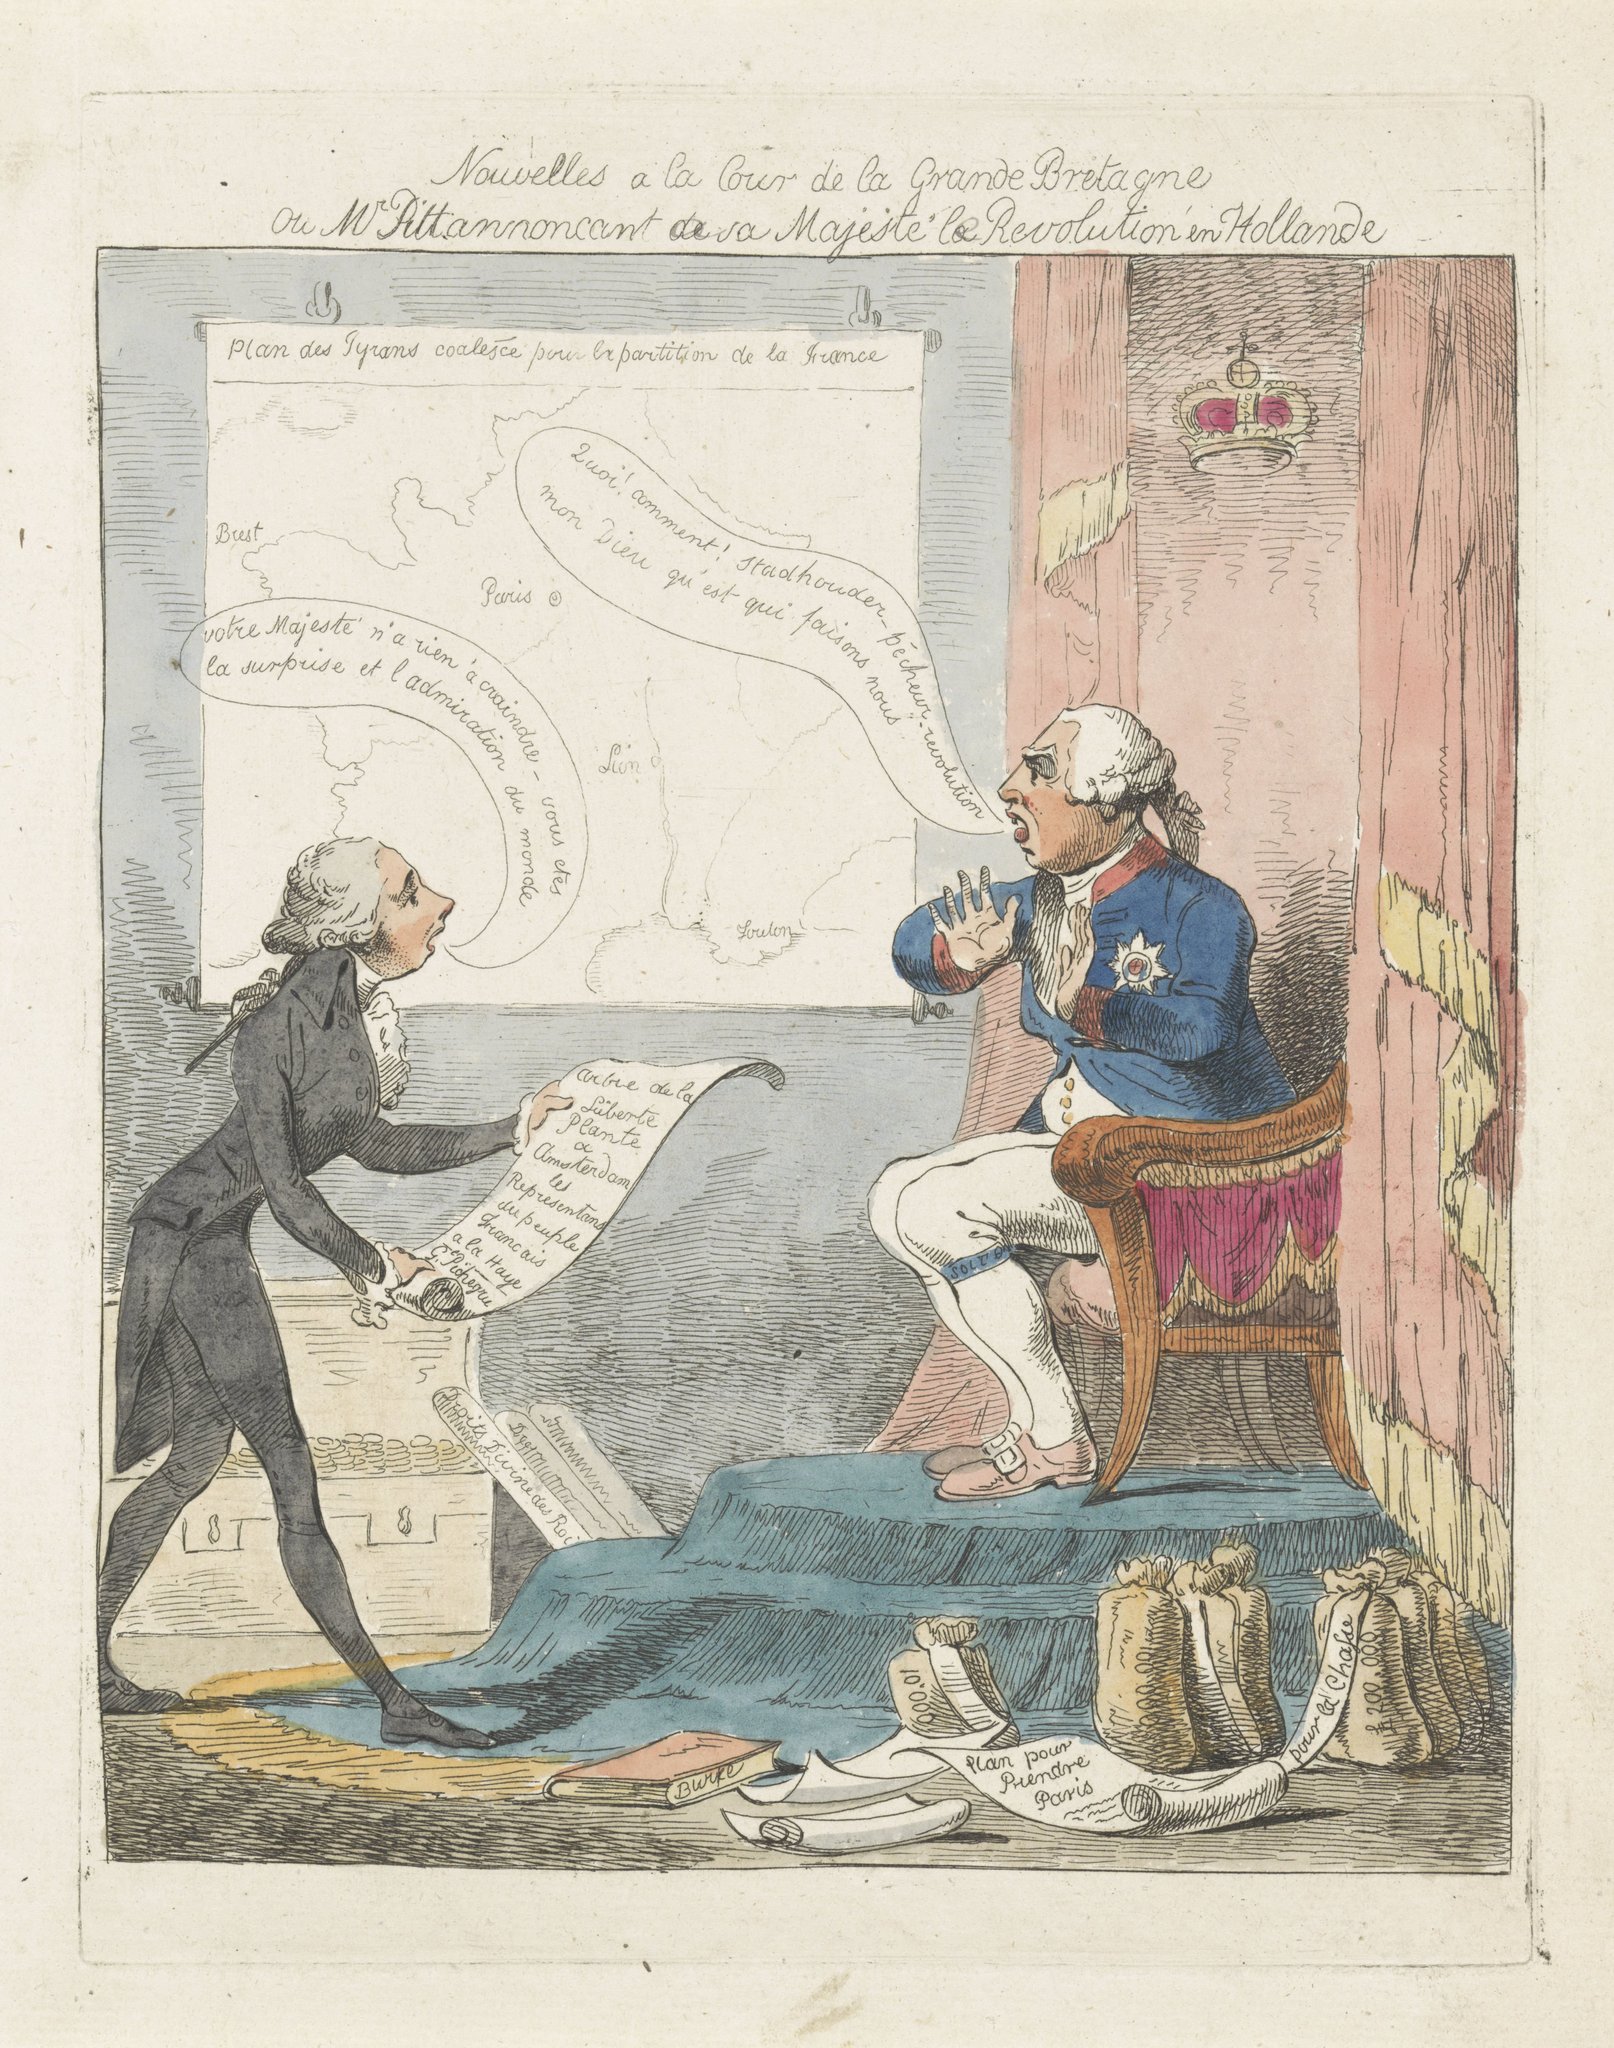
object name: print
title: Nouvelles a la Cour de la Grande Bretagne ou Mr. Pitt annoncant de sa Majesté la Revolution en Hollande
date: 1795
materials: paper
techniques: etching, hand coloring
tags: paris, politician, jean-charles pichegru, london, george iii (koning van het verenigd koninkrijk)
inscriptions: collector's mark: Lugt 2228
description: Spotprent waarin William Pitt de Engelse koning George III het slechte nieuws brengt van de Franse successen in Nederland. Het document in zijn hand verwijst naar het oprichten van de vrijheidsboom op de Dam te Amsterdam en Franse representanten te Den Haag en generaal Pichegru. Tegen de muur een kaart van Frankrijk, op de vloer zakken met geld.